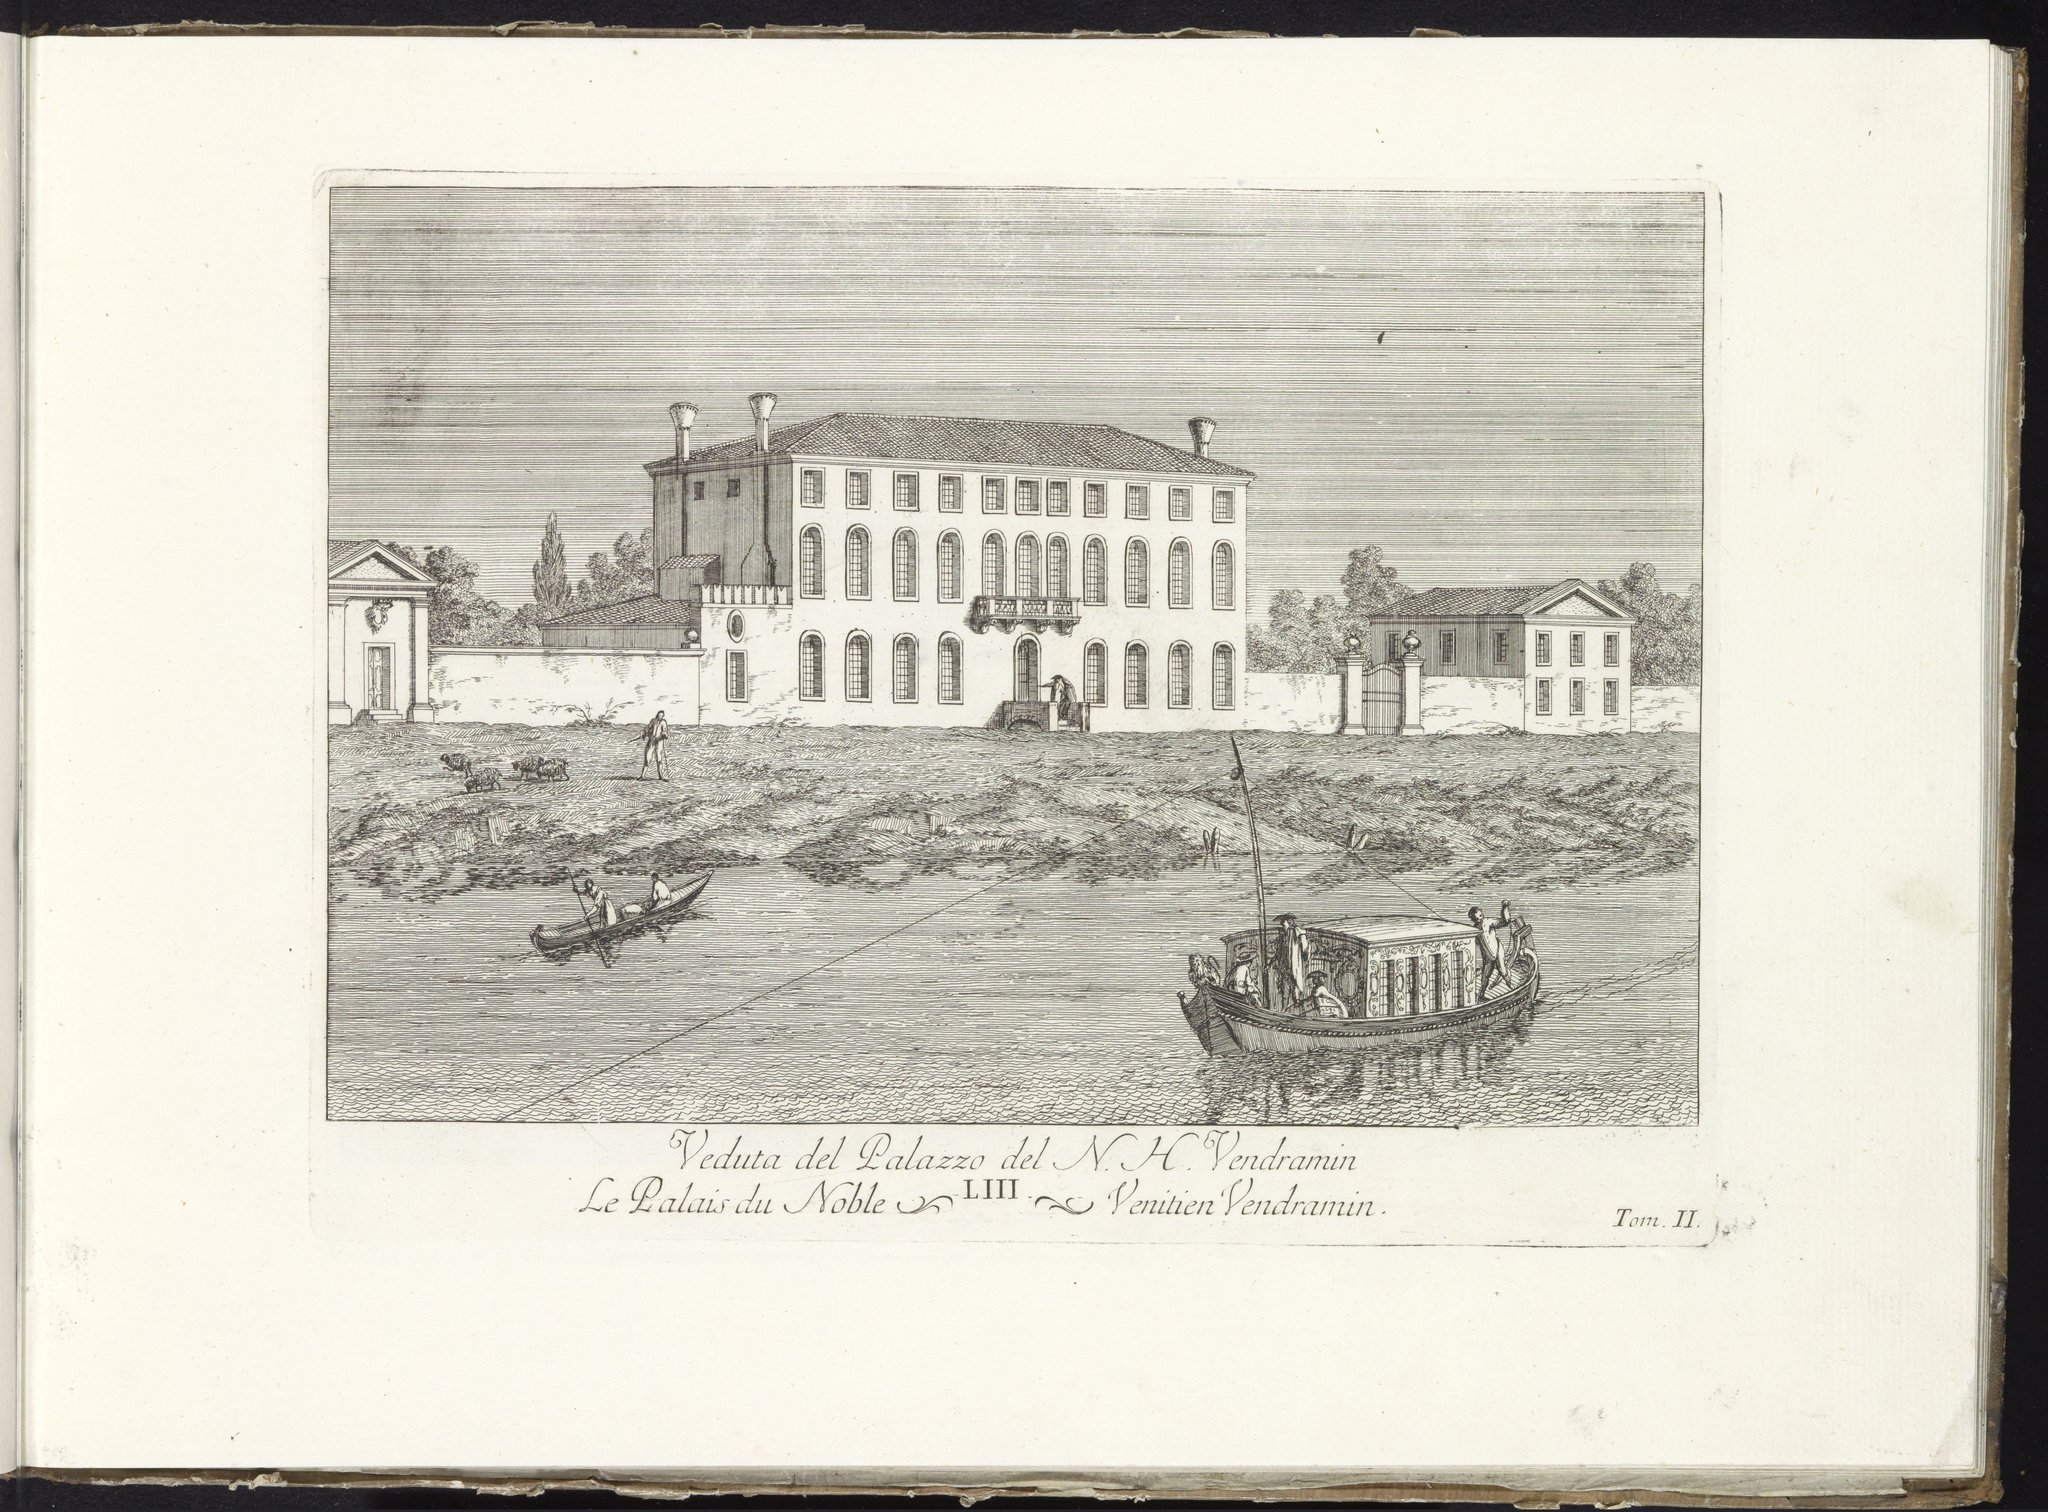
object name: print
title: Palazzo del N. H. Vendramin aan de Brenta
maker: giovanni francesco costa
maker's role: draughtsman, painter, print maker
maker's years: -1773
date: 1750-1760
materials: paper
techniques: etching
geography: venice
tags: river, tow-boat, towing-barge, hôtel, i.e. small palace in city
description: Gezicht op Palazzo del N. H. Vendramin aan de rivier de Brenta. Op het water varen een trekschuit en een roeiboot. Genummerd midden onder: LIII en rechtsonder: Tom: II. Deze prent maakt deel uit van een album.